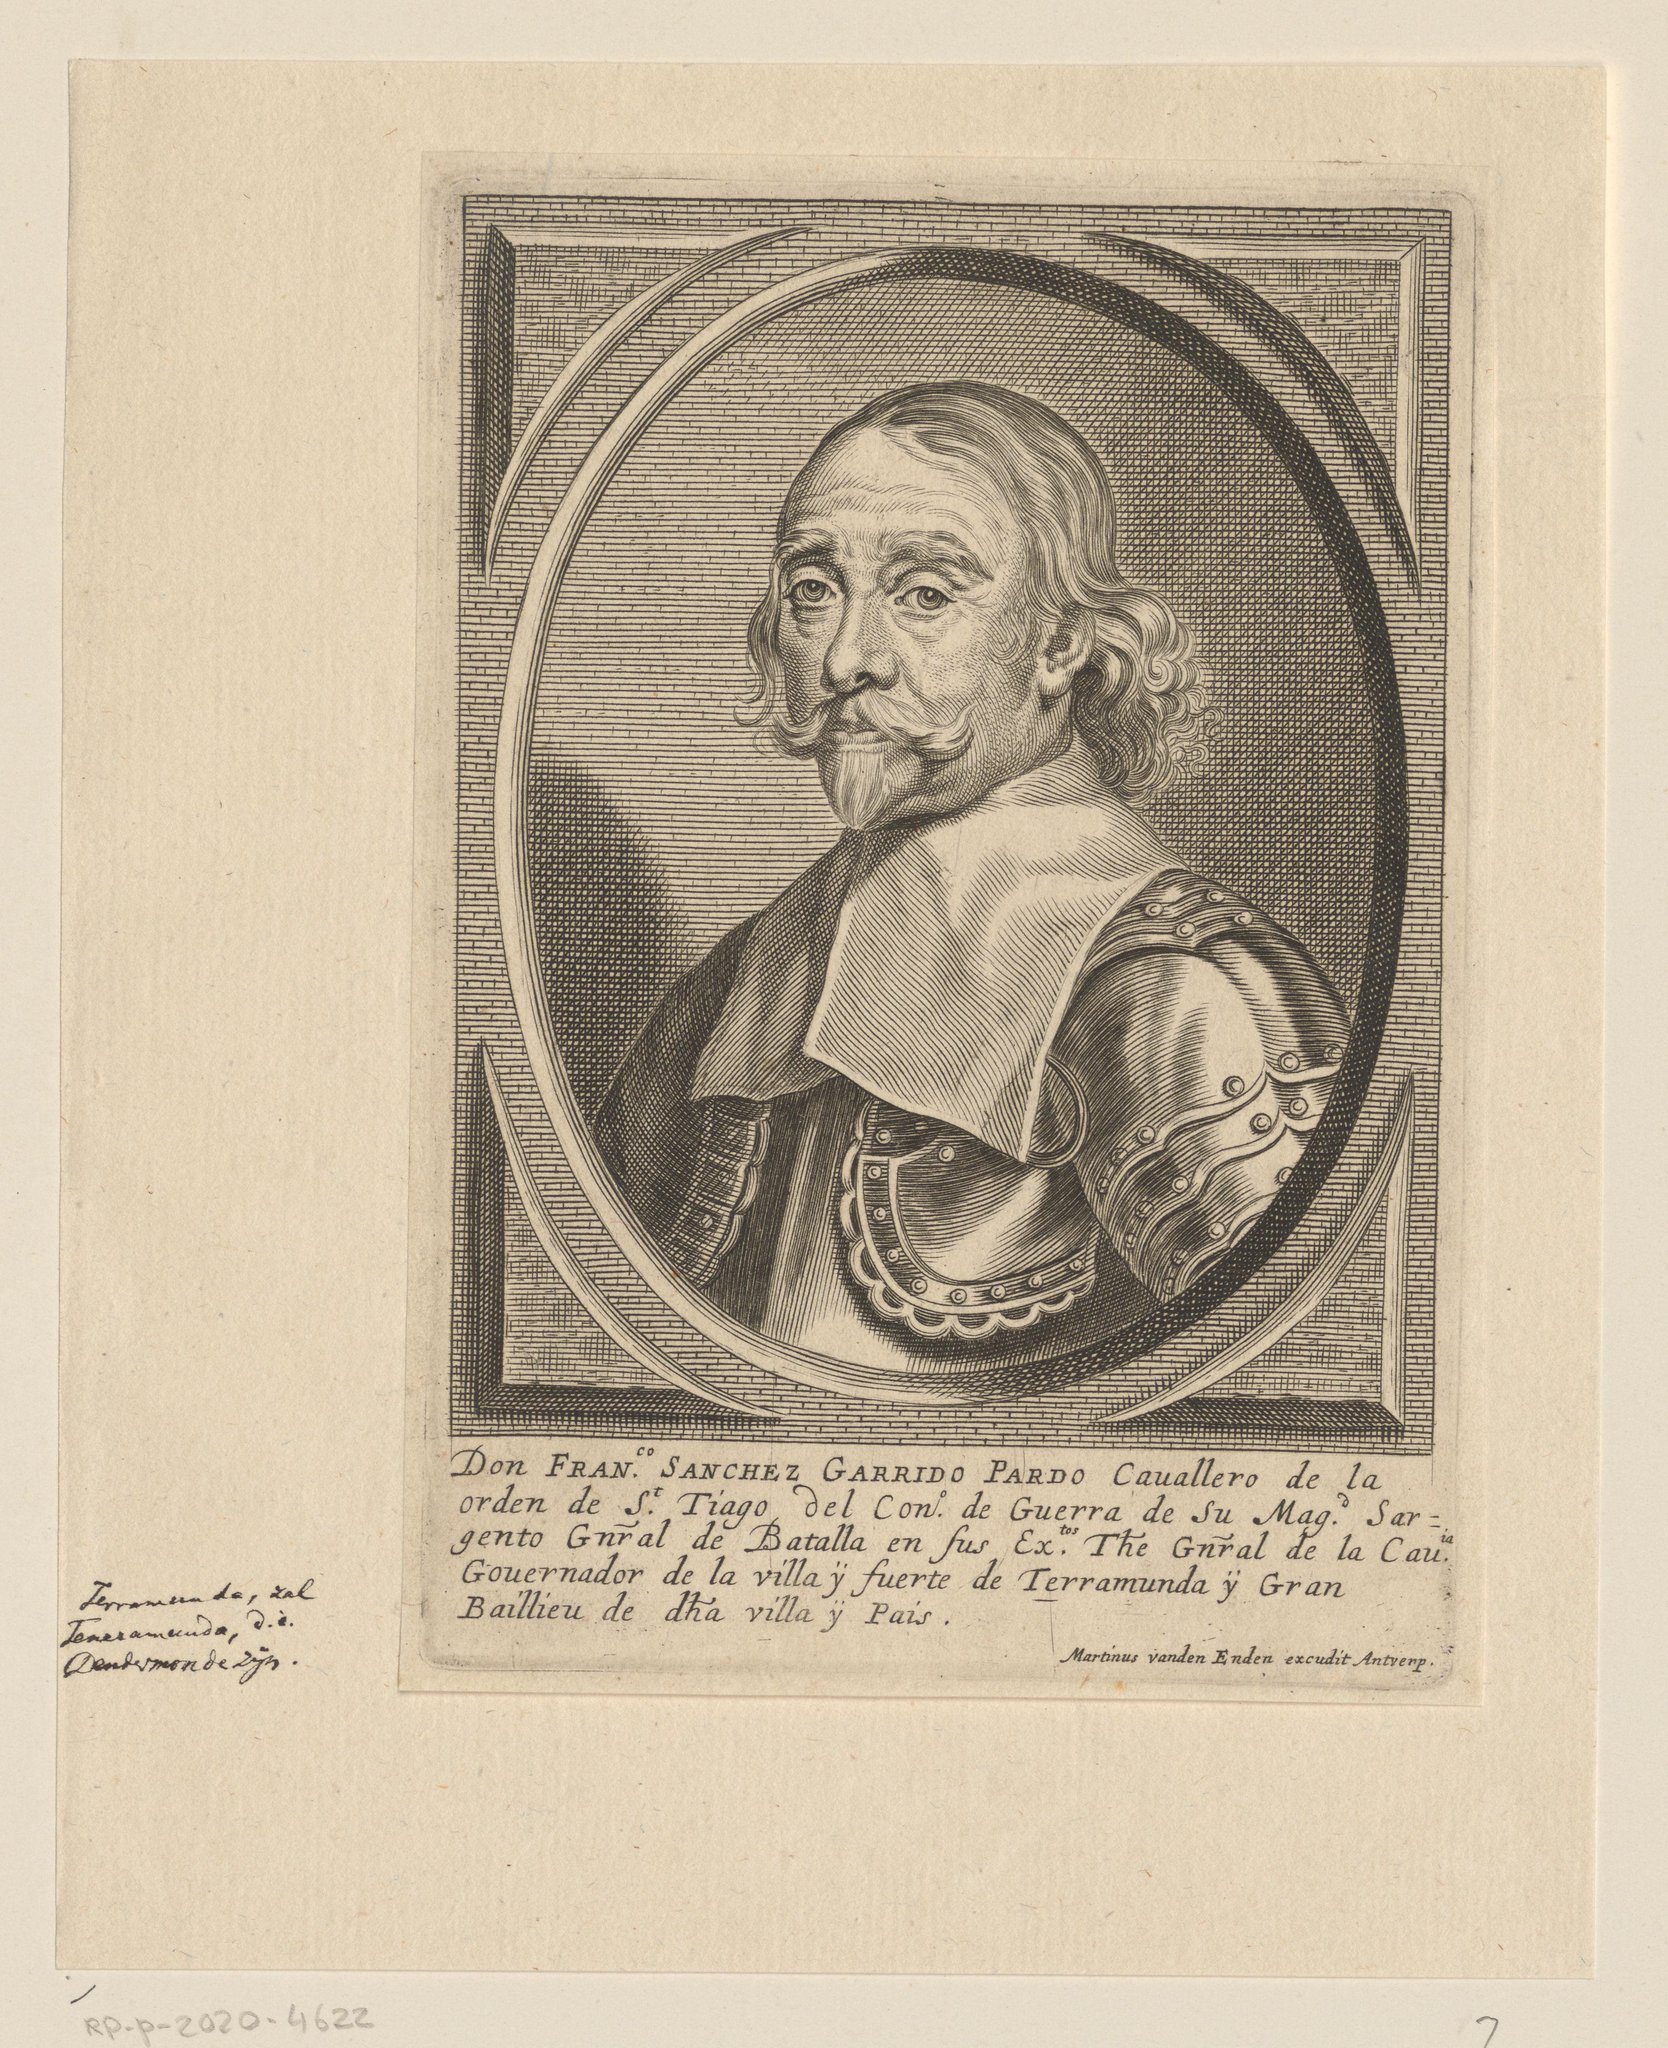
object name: print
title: Portret van Francisco Sanchez Garrido Pardo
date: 1630-1654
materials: paper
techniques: engraving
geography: antwerp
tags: official; civil servant; functionary (in general), historical persons